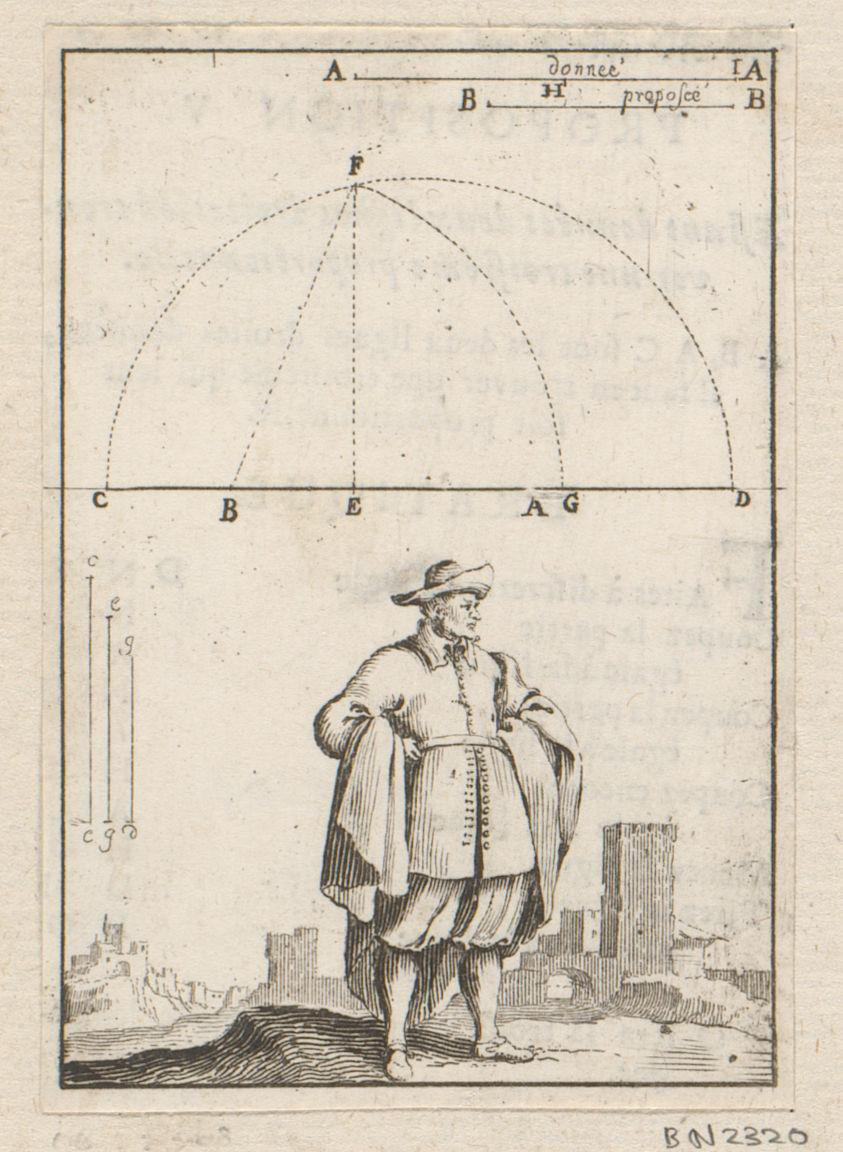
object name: print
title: Afsnijden van een deel van een rechte gegeven lijn met onderaan een staande man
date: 1669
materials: paper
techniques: etching, letterpress printing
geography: paris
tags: adult man, planimetry, geometry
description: Prent uit: Pratique de la géometrie, sur le papier et sur le terrain. Avec un nouvel ordre et une méthode particulière. Parijs: Thomas Jolly, 1669.